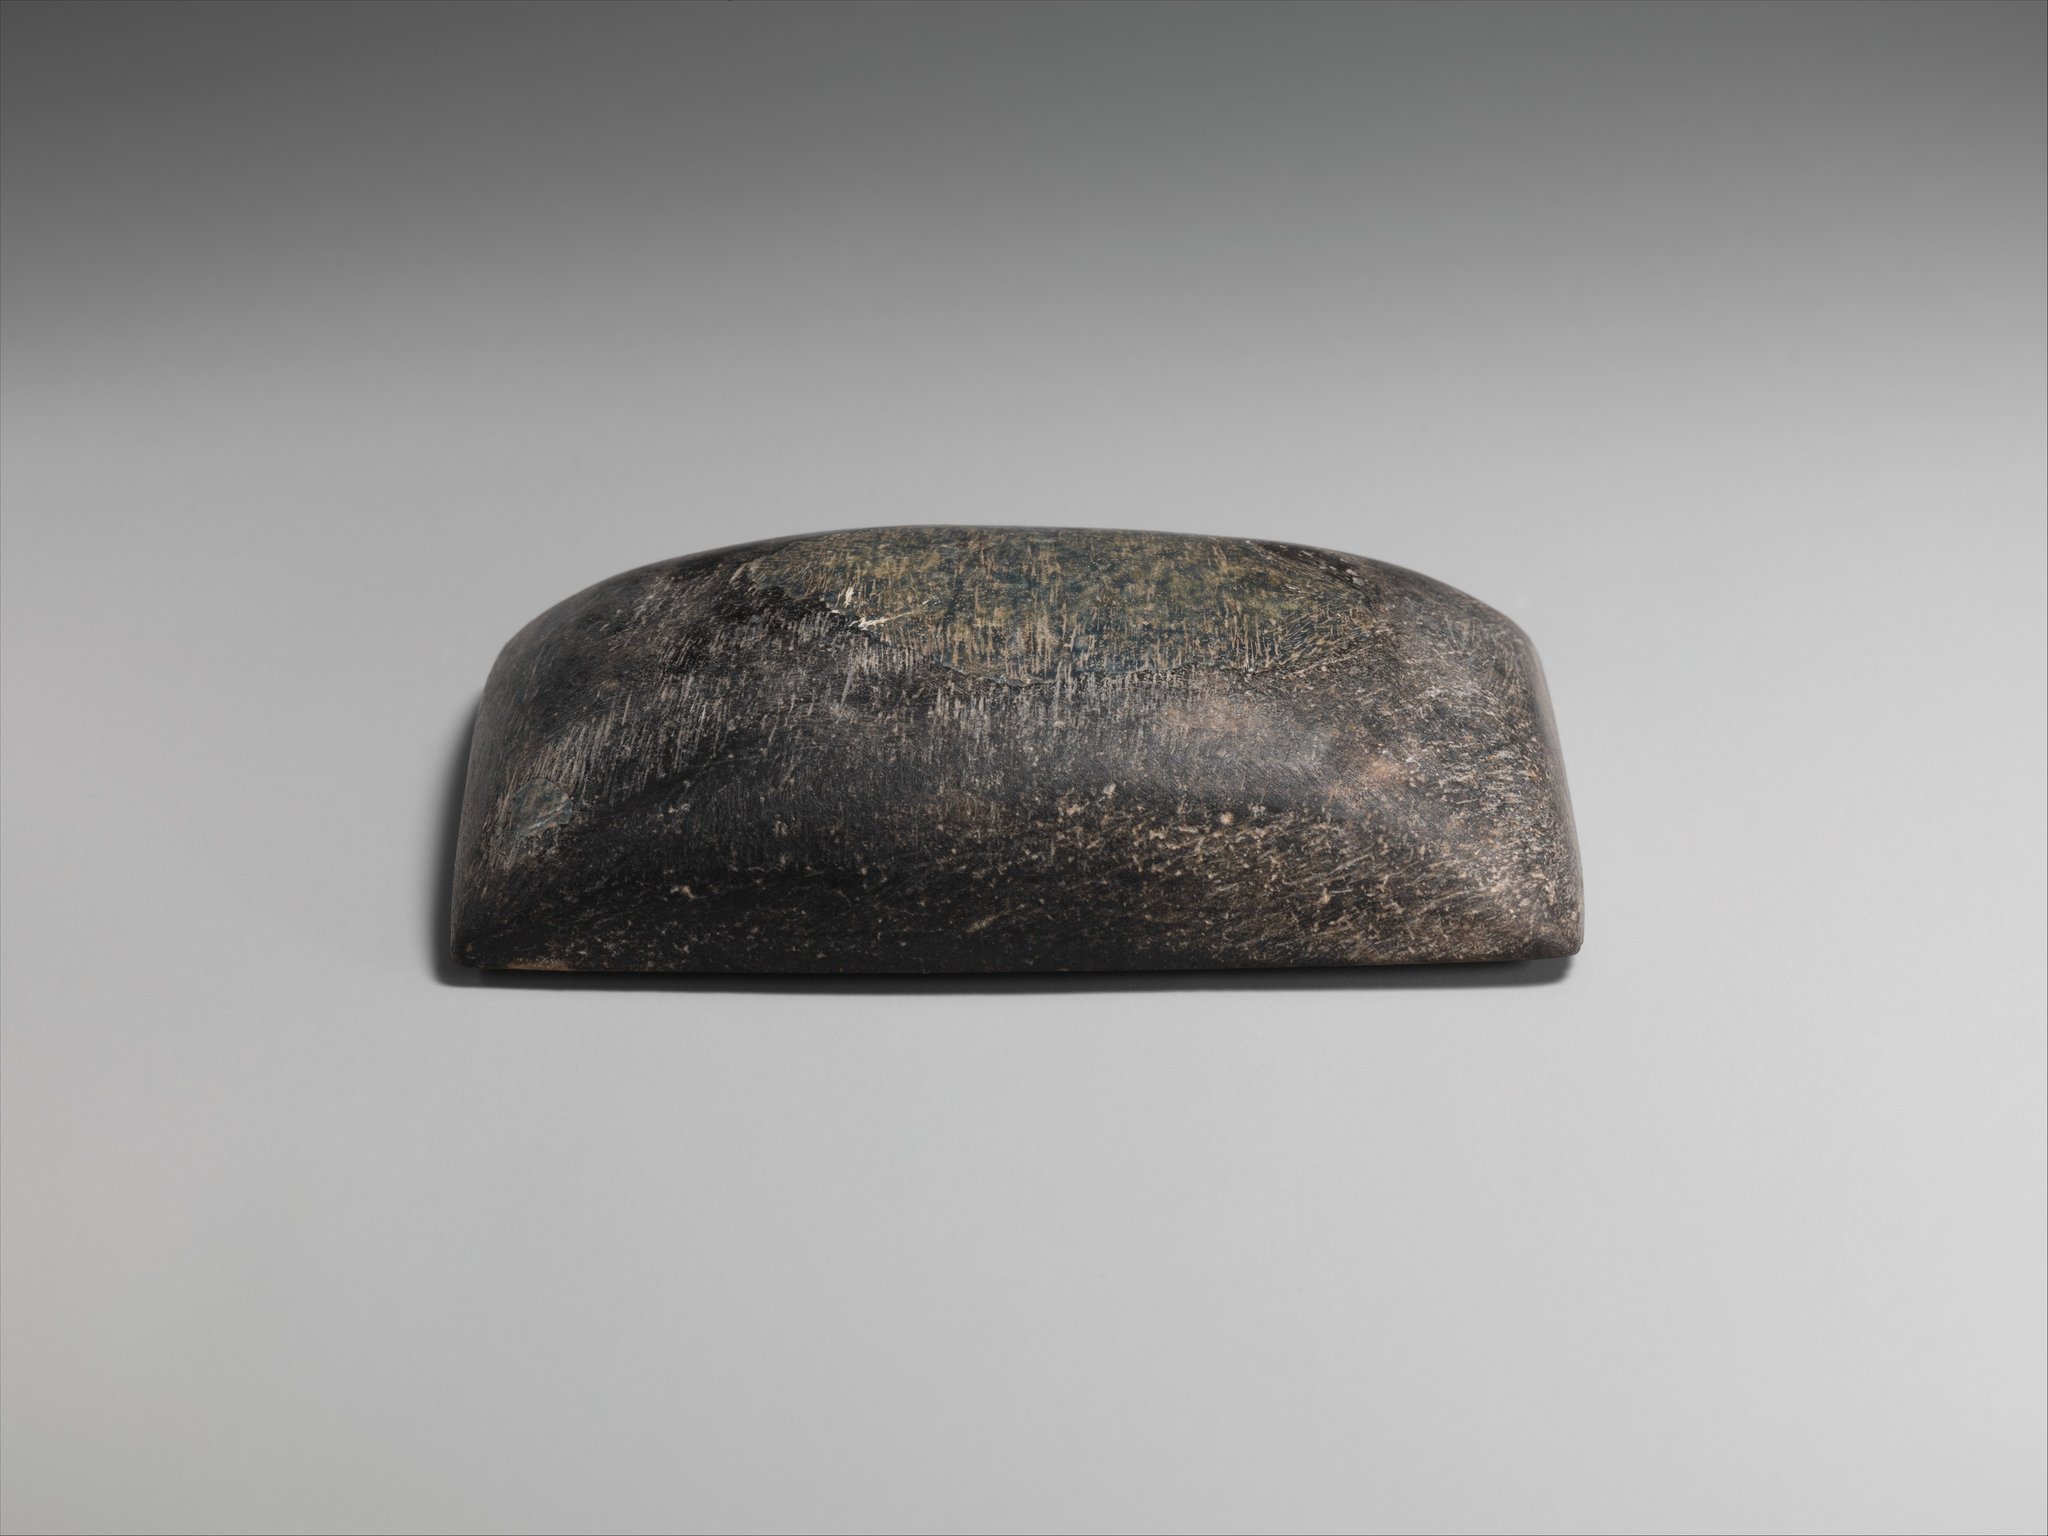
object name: model of brick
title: Model of a "plano-convex" brick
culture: neo-sumerian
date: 2112-2004 BCE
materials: limestone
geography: mesopotamia